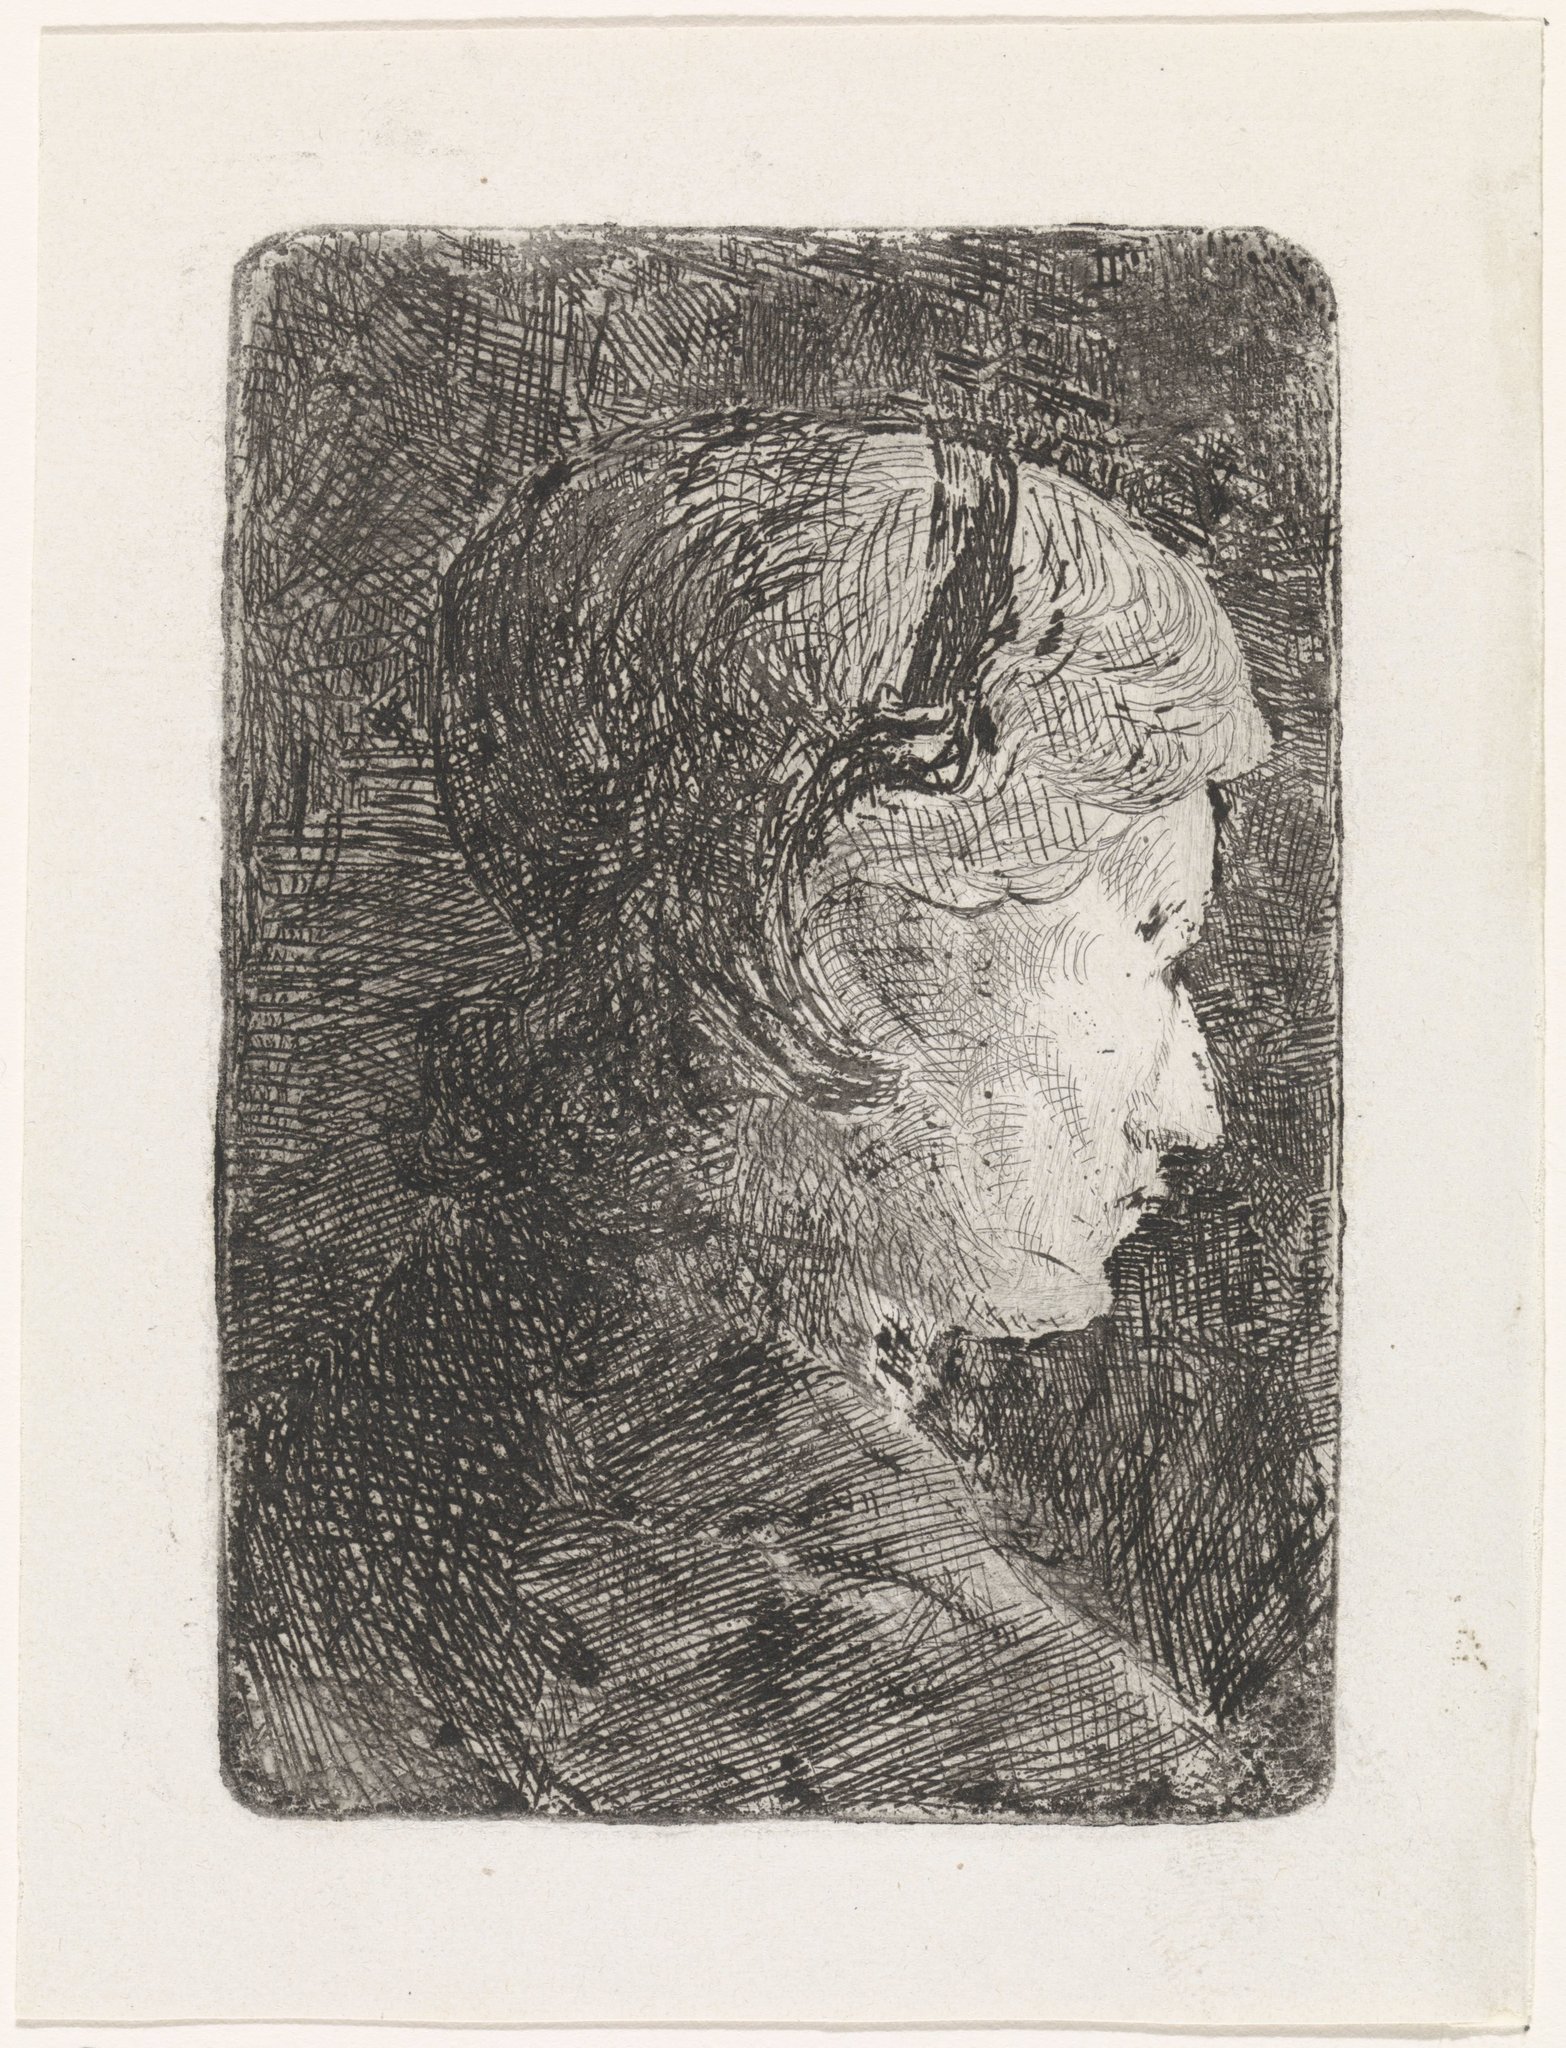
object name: print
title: Portret van Aleida Schaap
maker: jozef israëls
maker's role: draughtsman, painter, print maker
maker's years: 1824-1911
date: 1835-1888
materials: paper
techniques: etching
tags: the hague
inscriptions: collector's mark: Lugt 2228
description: Portret van Aleida Schaap, vrouw van kunstenaar Jozef Israëls, met haarband.